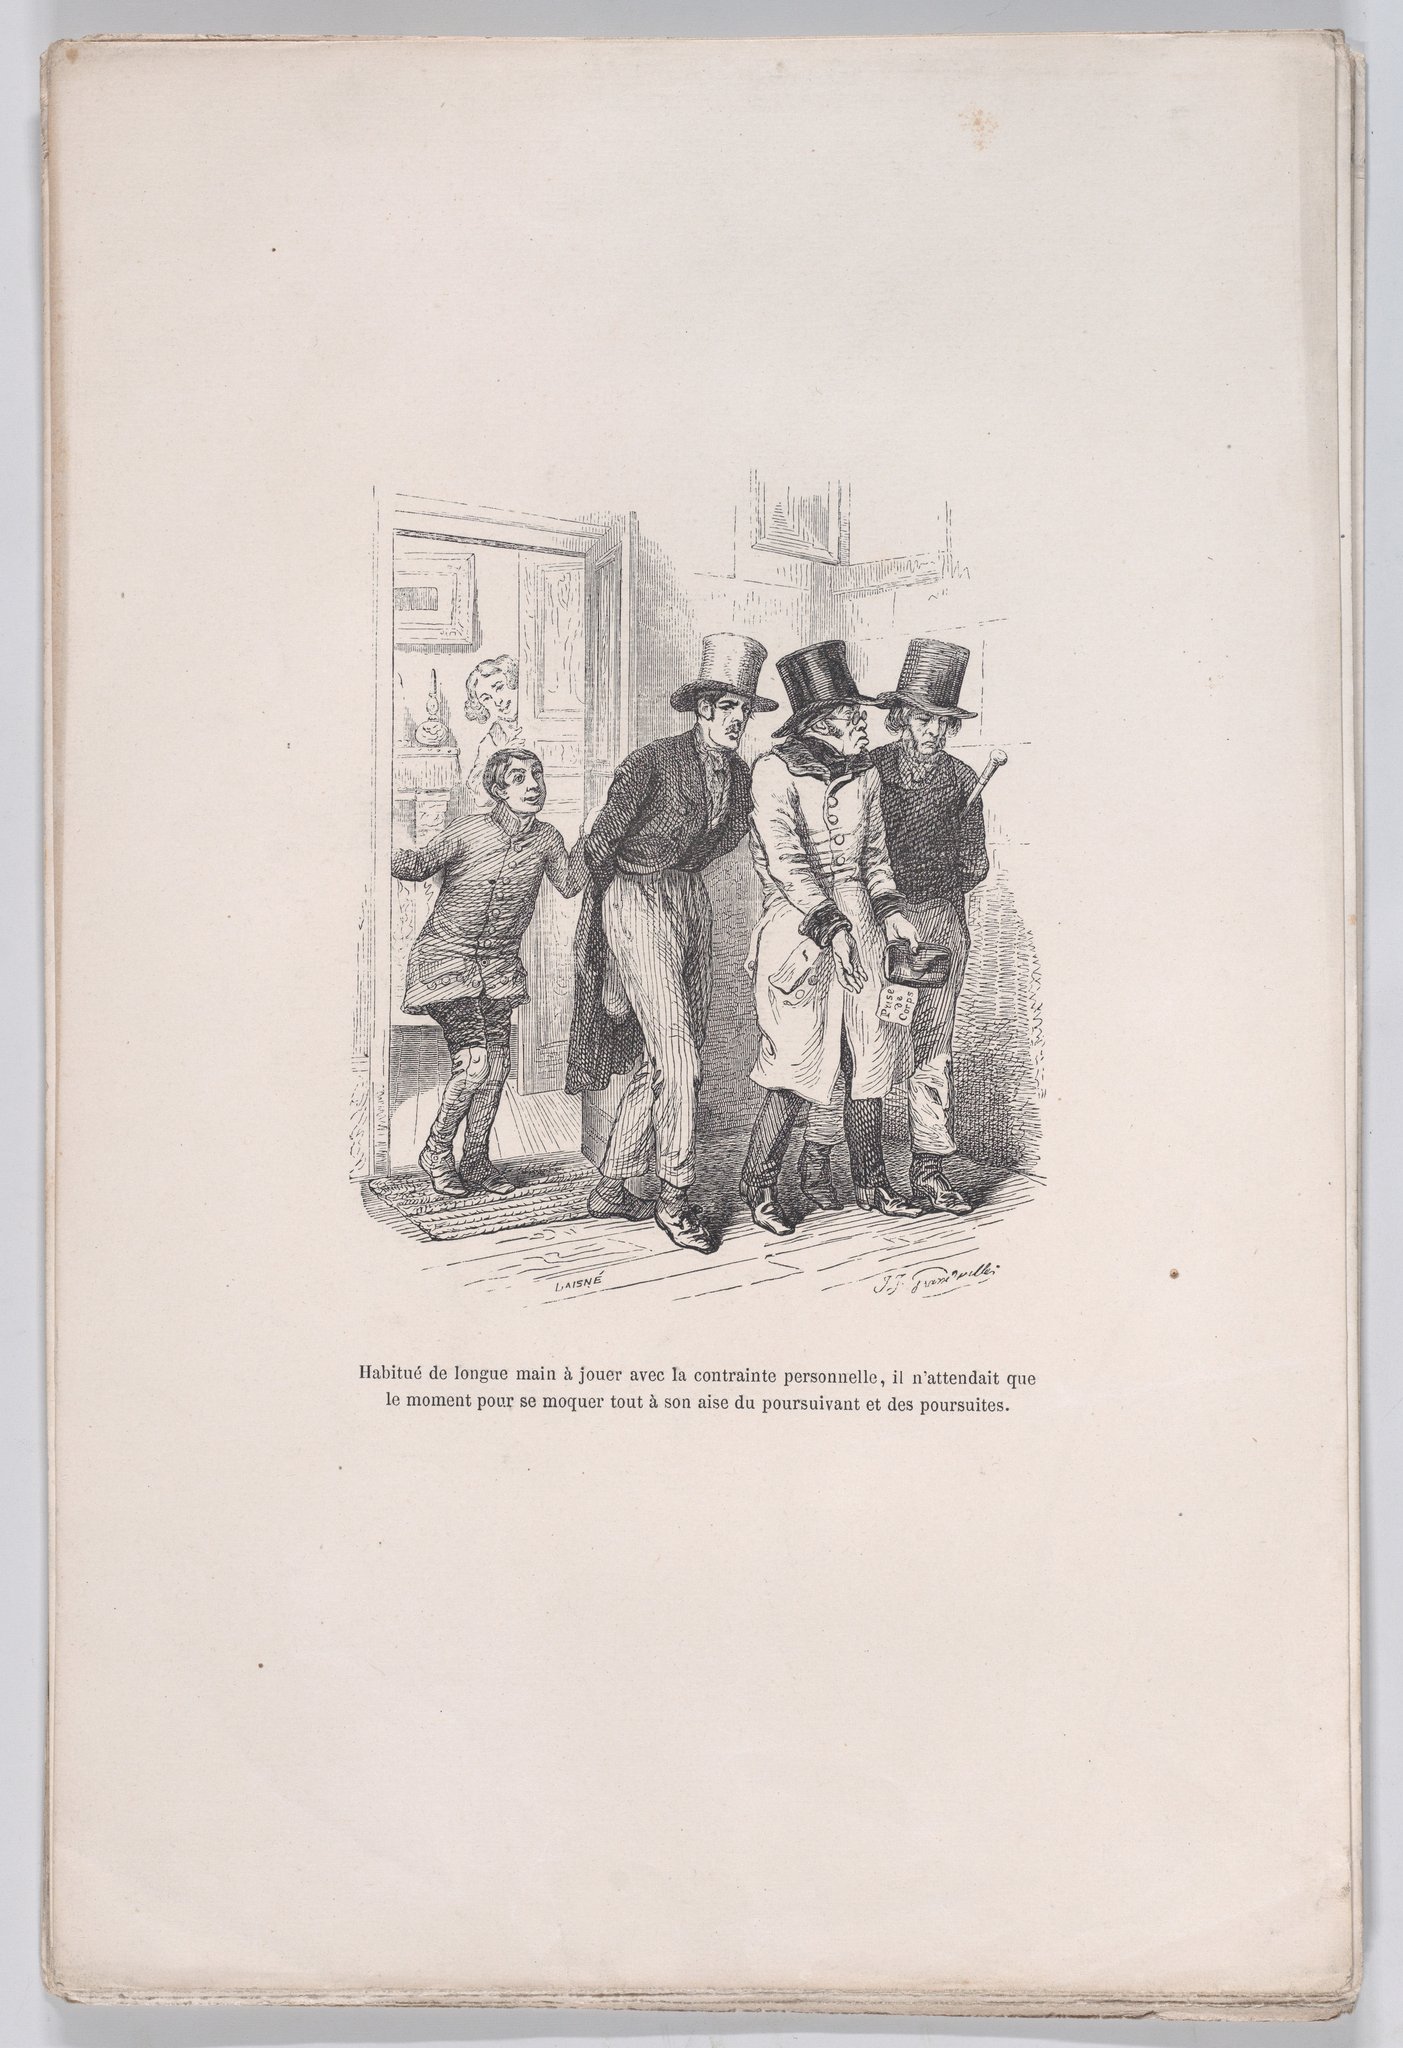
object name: print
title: He was only waiting to make fun of the pursuer and the pursuit, from "Little Miseries of Human Life"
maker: j. j. grandville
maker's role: illustrator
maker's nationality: french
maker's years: 1803-1847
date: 1843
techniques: engraving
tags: men